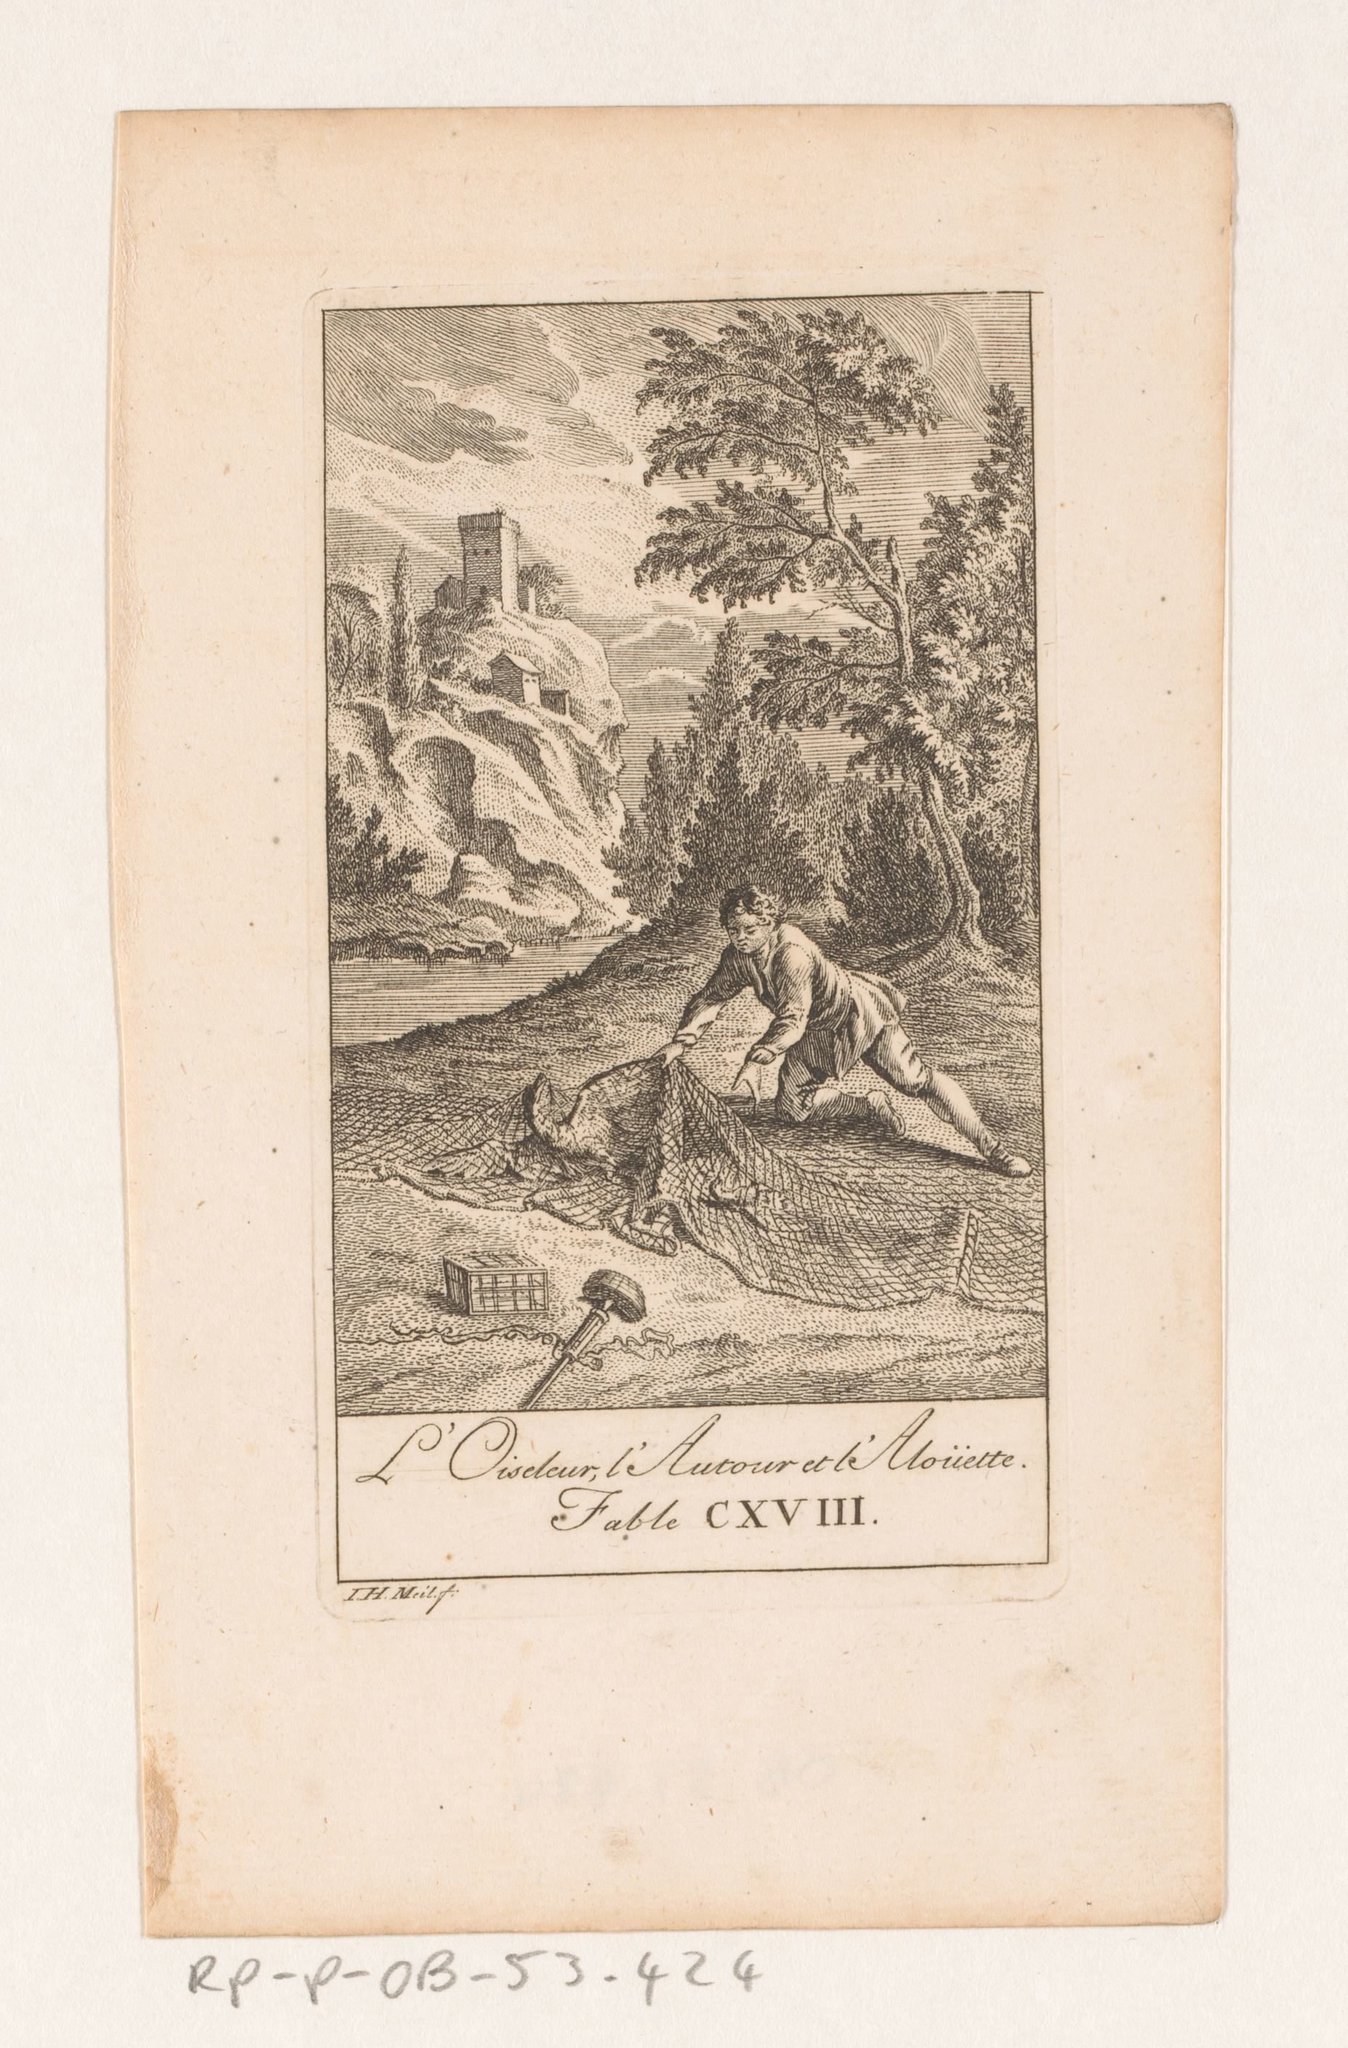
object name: book illustration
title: Fables choisies, mises en vers par J. de la Fontaine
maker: johann heinrich meil (der ältere)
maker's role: print maker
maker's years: 1730-1820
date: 1758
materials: paper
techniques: etching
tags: fables of lafontaine : use 85(...), bird hunting, predatory birds: hawk, song-birds: lark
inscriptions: collector's mark: Lugt 2228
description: Illustratie uit: Fontaine, J. de la. Fables choisies, mises en vers. Dl. 2. Dresden & Leipzig: George Conrad Walther, 1758.